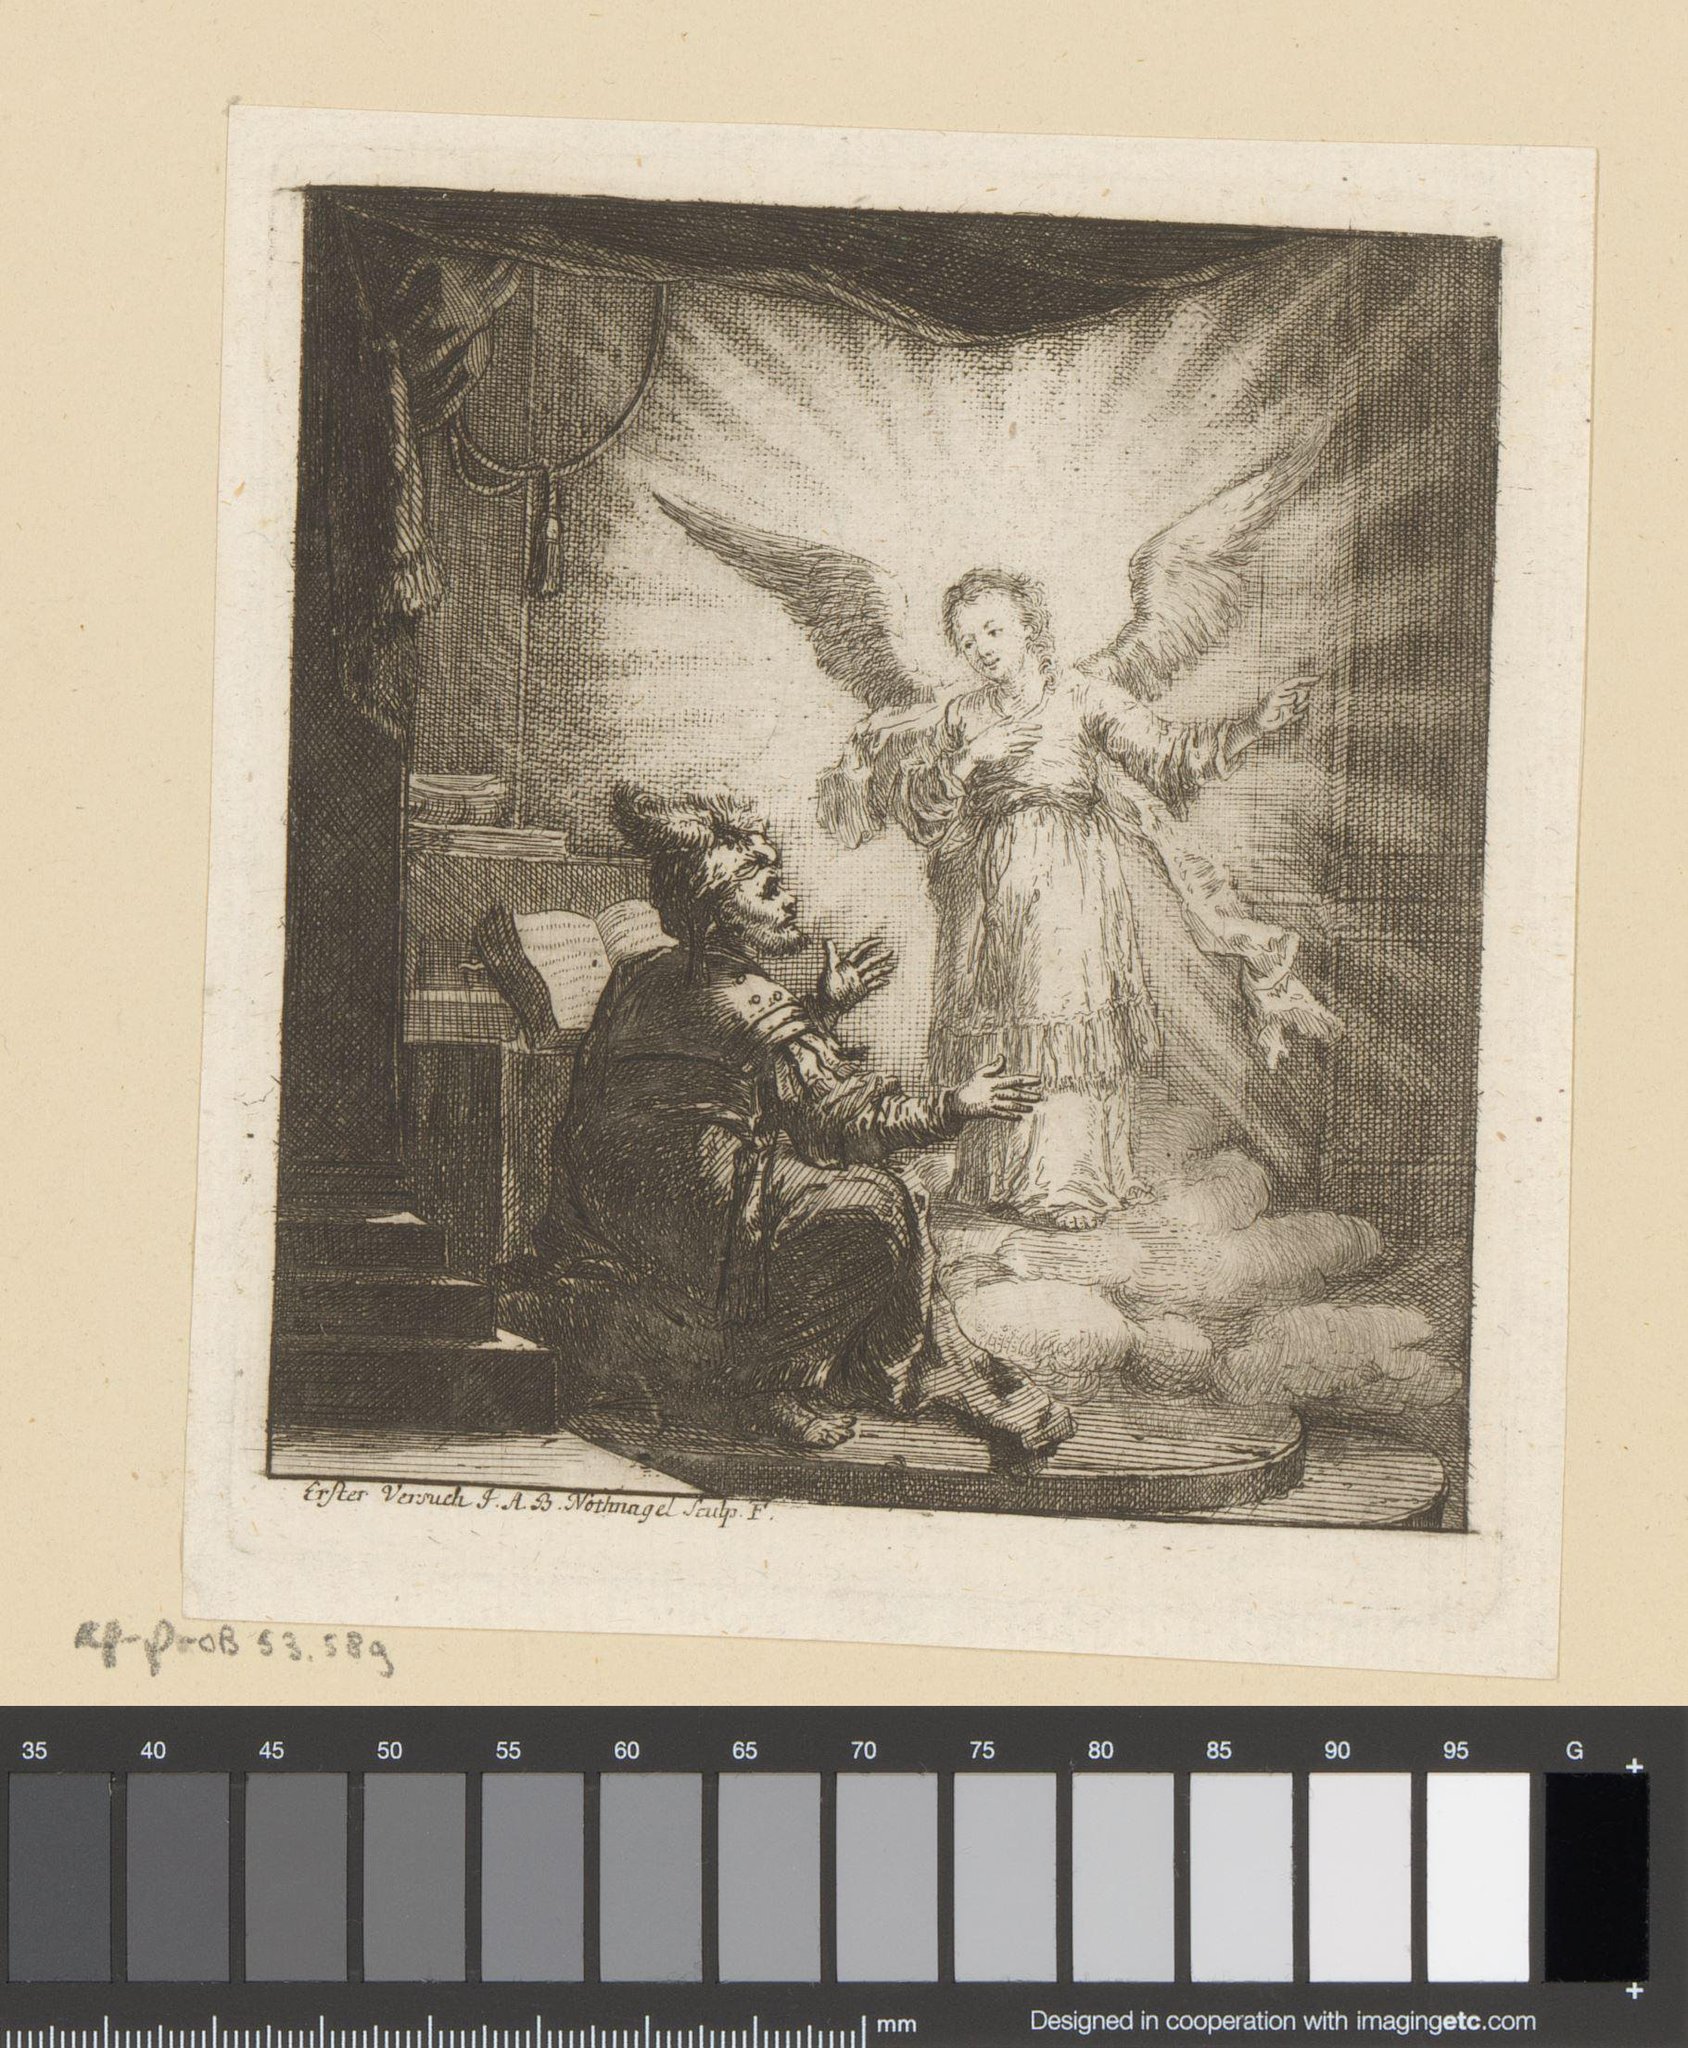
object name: print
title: Engel verschijnt aan Cornelius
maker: johann andreas benjamin nothnagel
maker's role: print maker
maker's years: 1729-1804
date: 1739-1804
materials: paper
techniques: etching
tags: cornelius the centurion and the angel